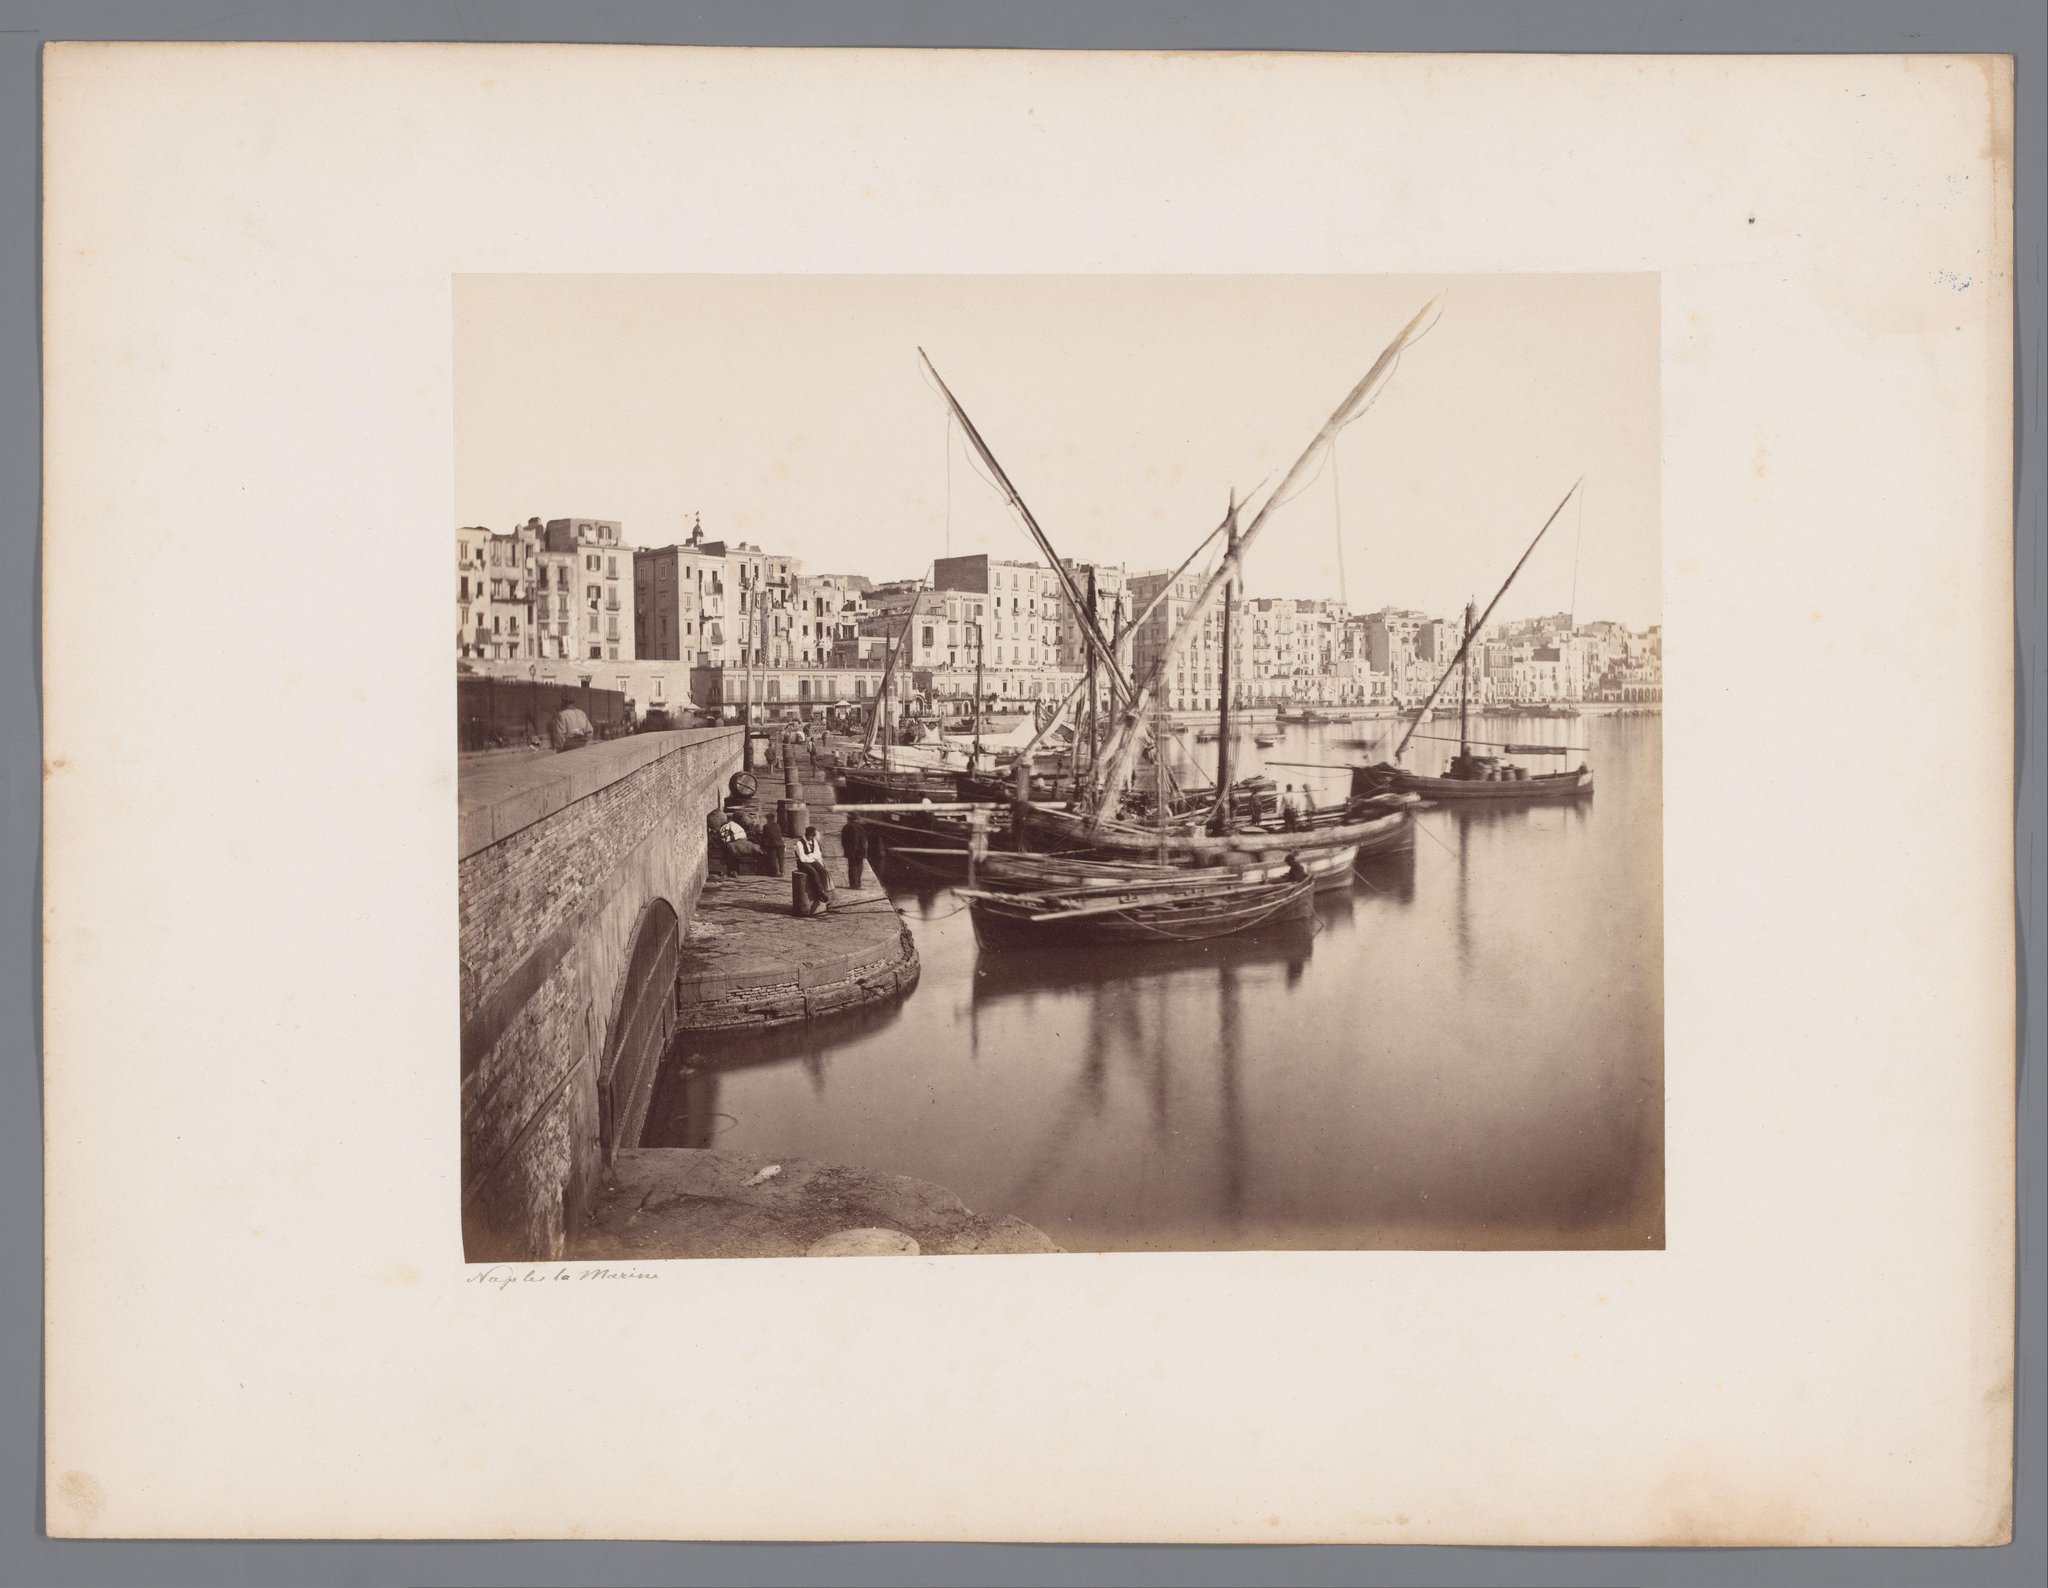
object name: photograph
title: Naples la Marine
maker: Anonymous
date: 1851-1900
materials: cardboard, paper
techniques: albumen print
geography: naples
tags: harbour, sailing-ship, sailing-boat, naples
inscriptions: number: ‘13.’, number: ‘12’